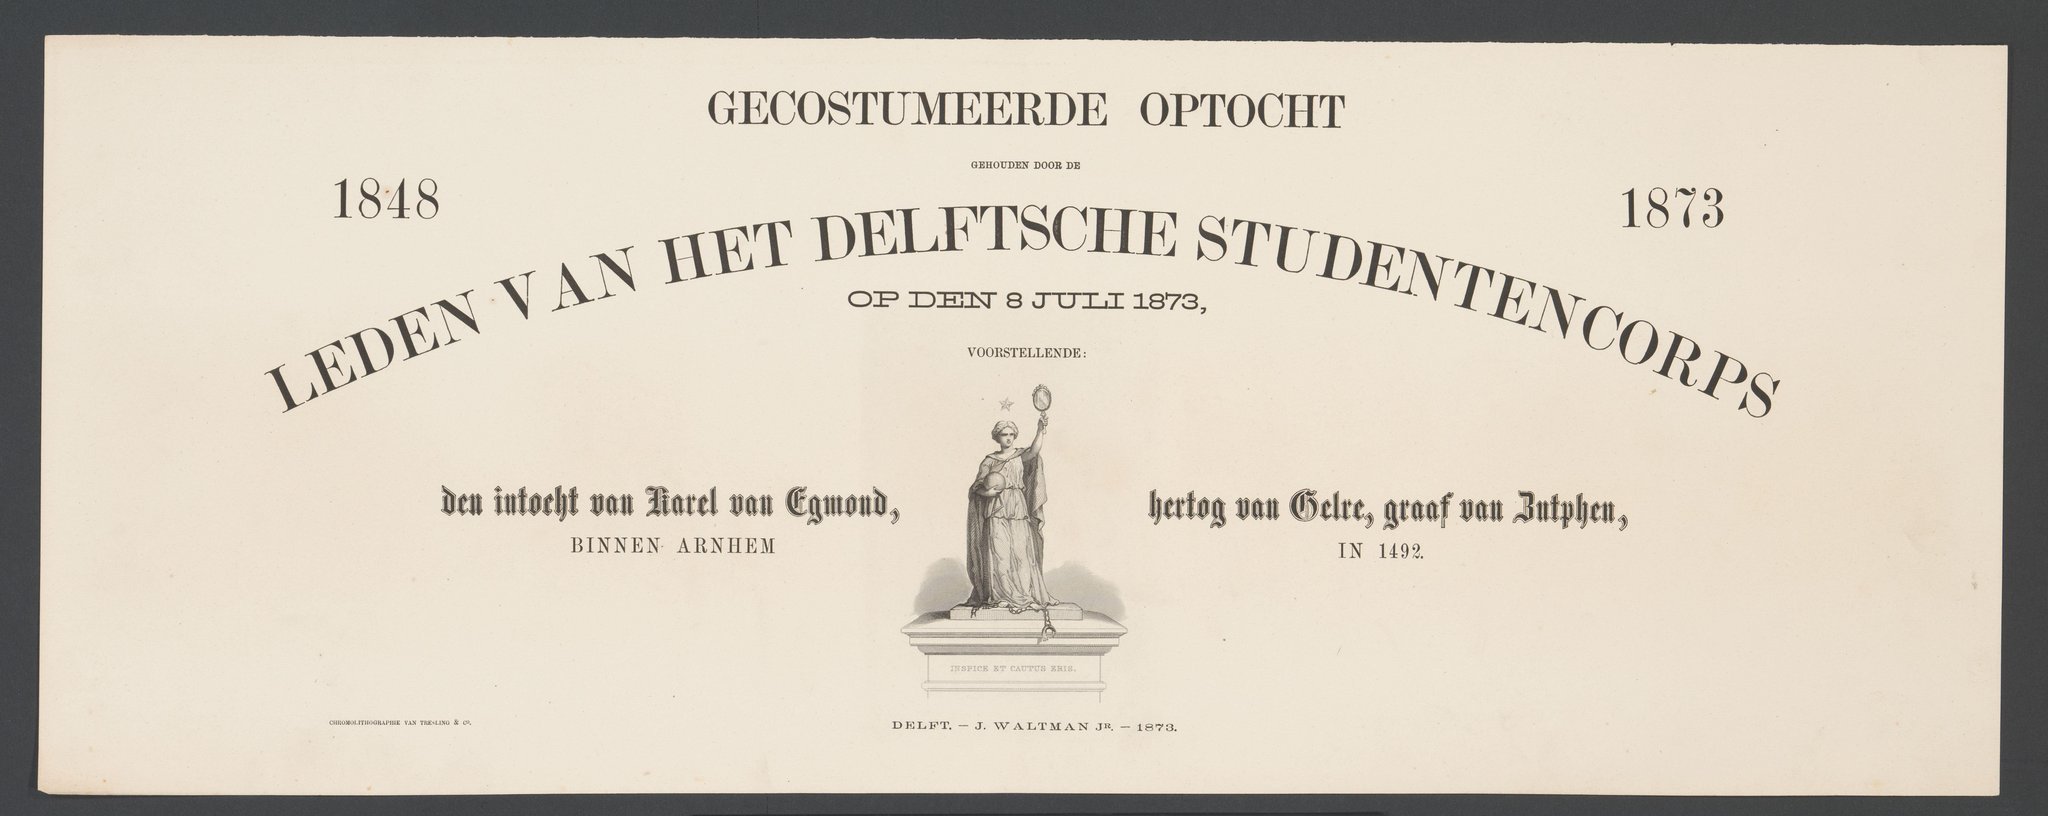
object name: wrapper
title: Gecostumeerde optocht gehouden door de leden van het Delftsche Studentencorps op den 8 Juli 1873, voorstellende: den intocht van Karel van Egmond, hertog van Gelre, graaf van Zutphen, binnen Arnhem in 1492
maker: j. waltman (drukker)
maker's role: printer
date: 1873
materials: cardboard, linen, paper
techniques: lithograph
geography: amsterdam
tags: university, grave, arnhem, earl, karel van egmond, students' pageant, costumes used in pageants, delft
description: Kartonnen omslag voor de tien platen plus een titel van de historische gekostumeerde optocht door de studenten van de Polytechnische Hogeschool van Delft op 8 juli 1873. De optocht verbeeldt de intocht van Karel van Egmond in Arnhem in 1492. Op de omslag de typografische titel en een vignet. Omslag met geel papier, rood linnen rug en rode linten op drie plekken.